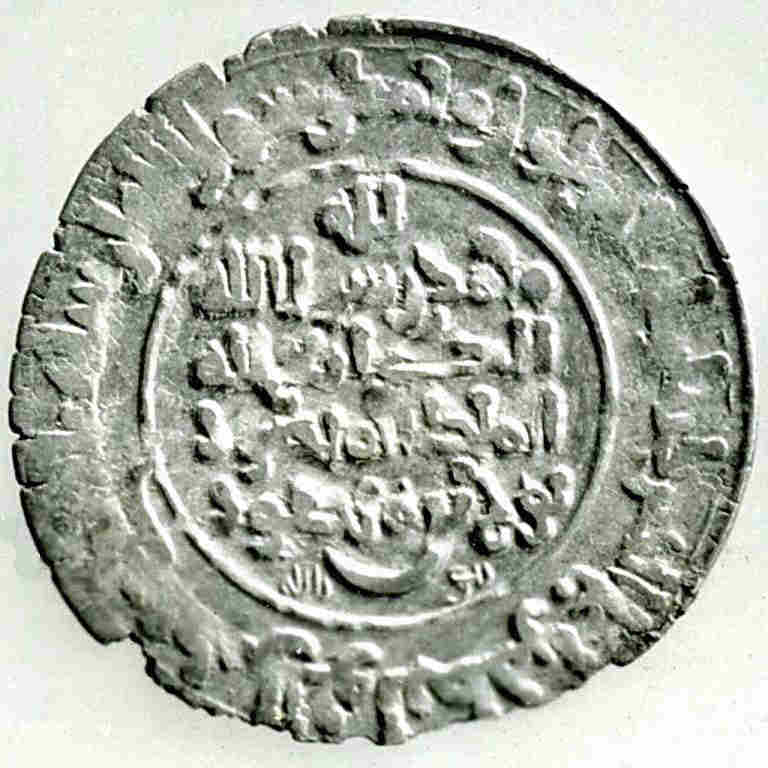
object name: coin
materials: silver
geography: uzbekistan